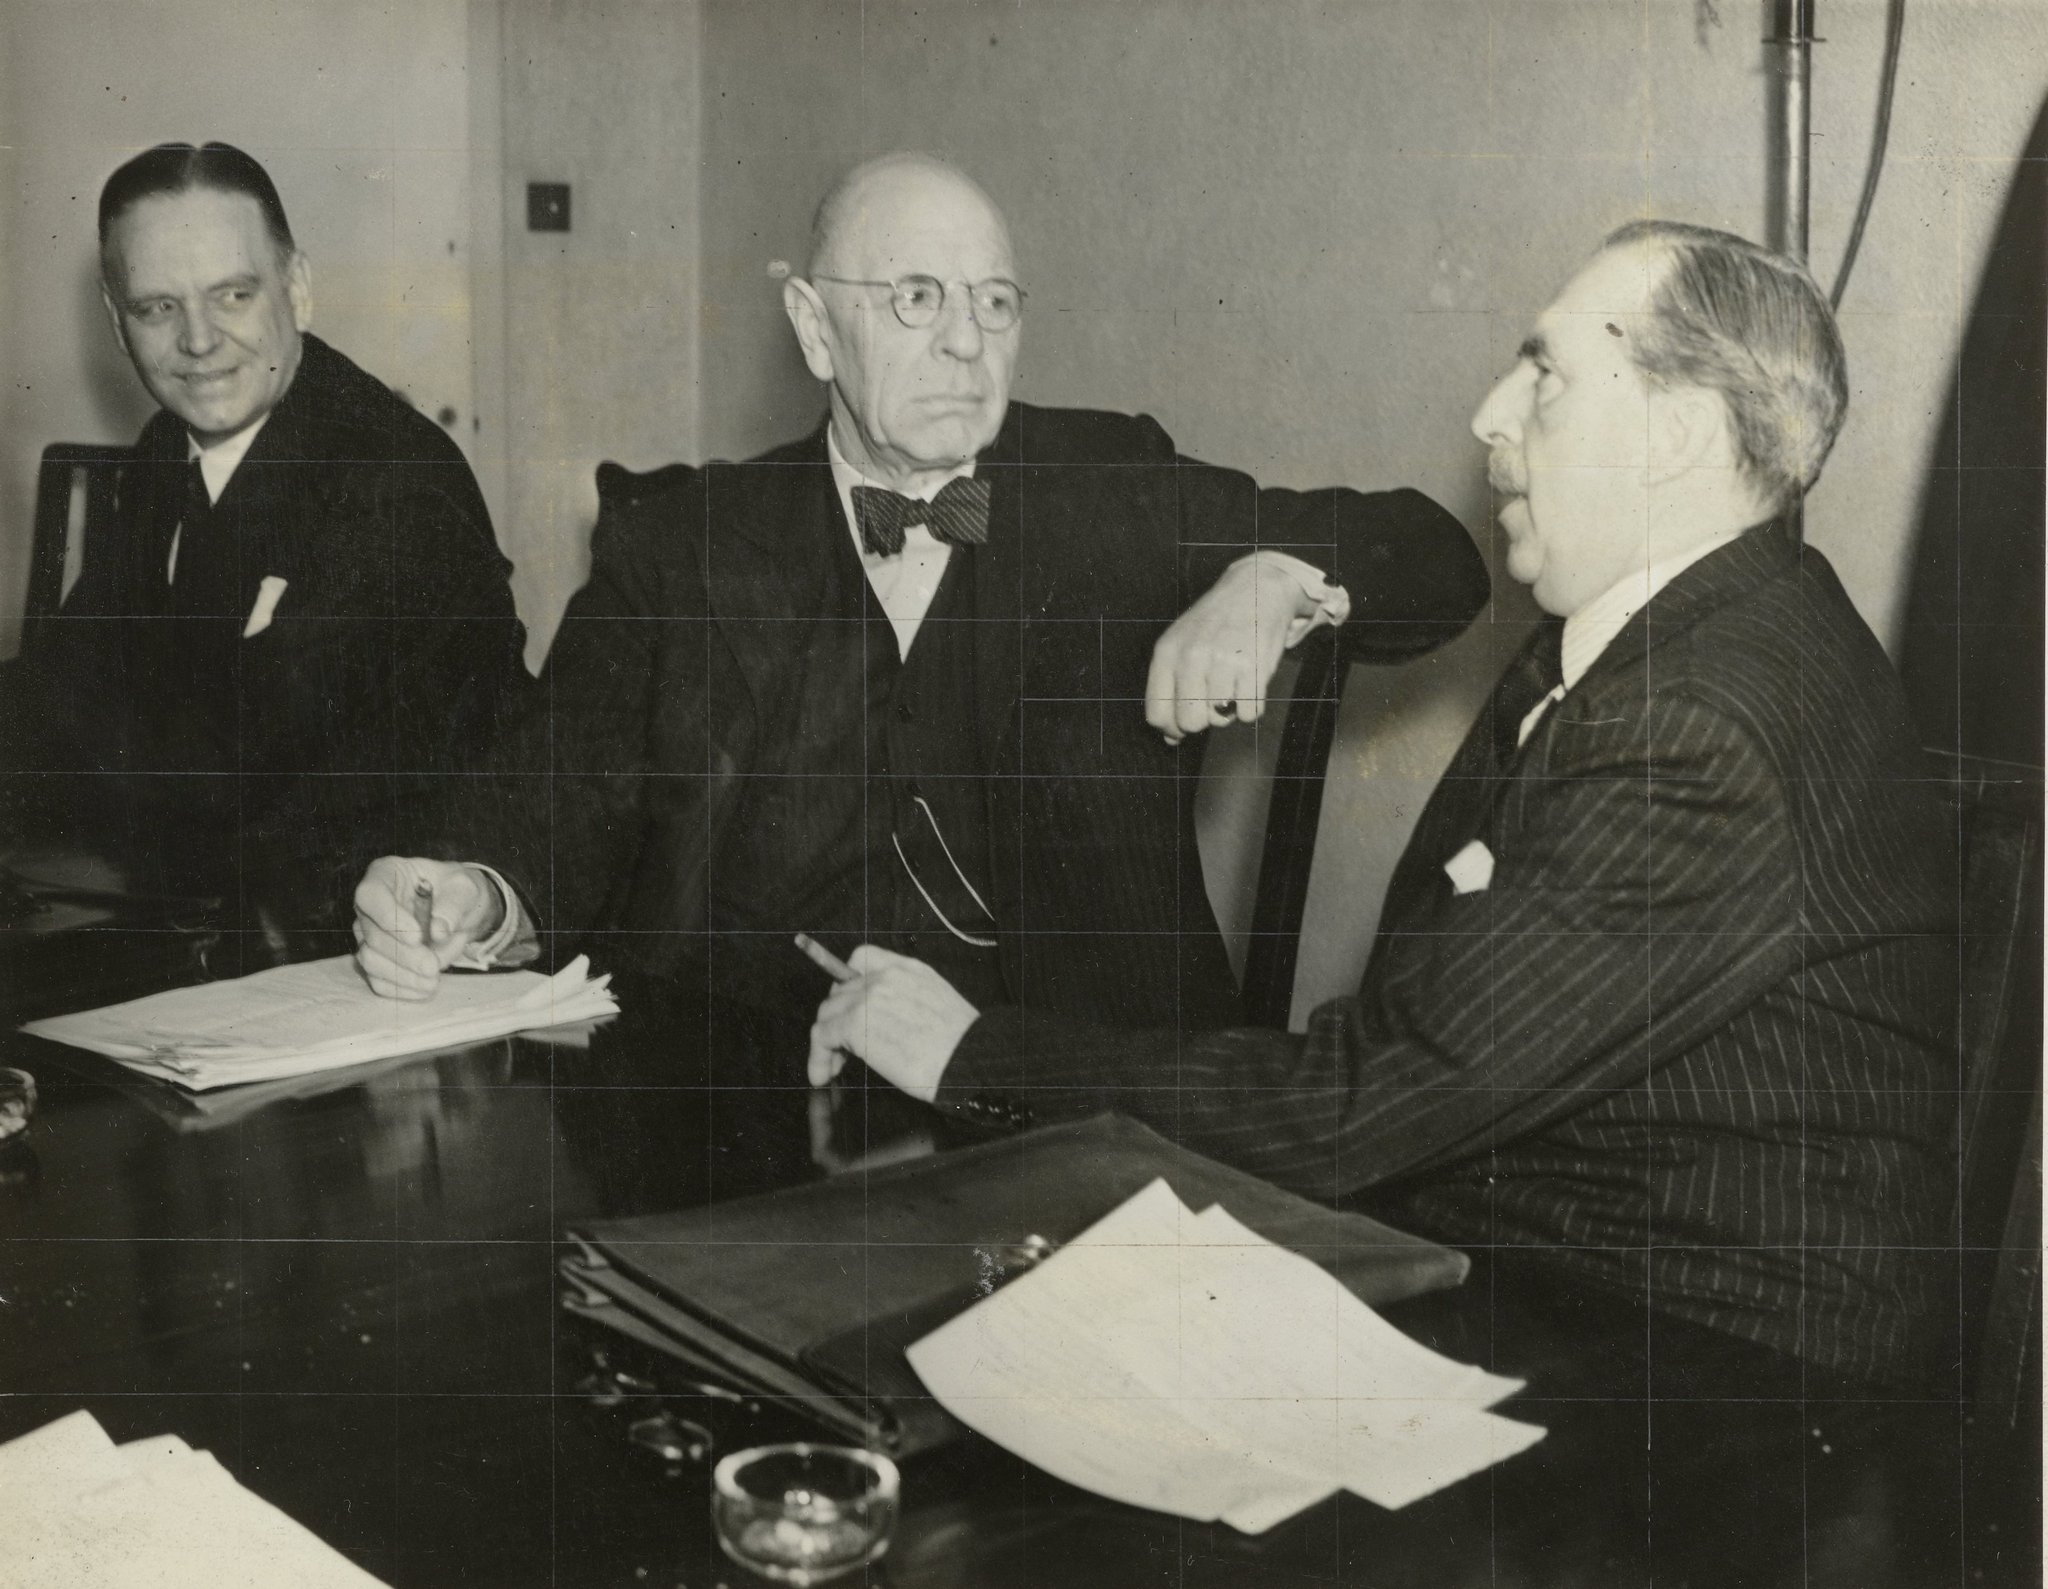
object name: photograph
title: De ministers Alberda, Michiels van Verduynen en Kerstens in gesprek.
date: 1943-1945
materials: photographic support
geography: london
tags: pieter sjoerds gerbrandy, the hague, london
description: Minister Johan Willem Alberda (1877-1957, midden) in gesprek met Mr. E.F.M.J. baron Michiels van Verduynen, minister zonder portefeuille. Verduynen kon de minister van Buitenlandse Zaken vervangen als deze in het buitenland verbleef. Alberda werd in 1939 één van de eerste SDAP-ministers. De Fries werd minister van Waterstaat in het Kabinet-De Geer II. Kort hierna bezetten de Duitsers Nederland en vluchtte Alberda met de Nederlandse regering naar Engeland. Gedurende de oorlog nam Alberda deel aan de Londense kabinetten onder leiding van Pieter Gerbrandy. Links op de foto staat minister Kerstens. Het lijnennet is aangebracht door kunstenaar Cor Visser.